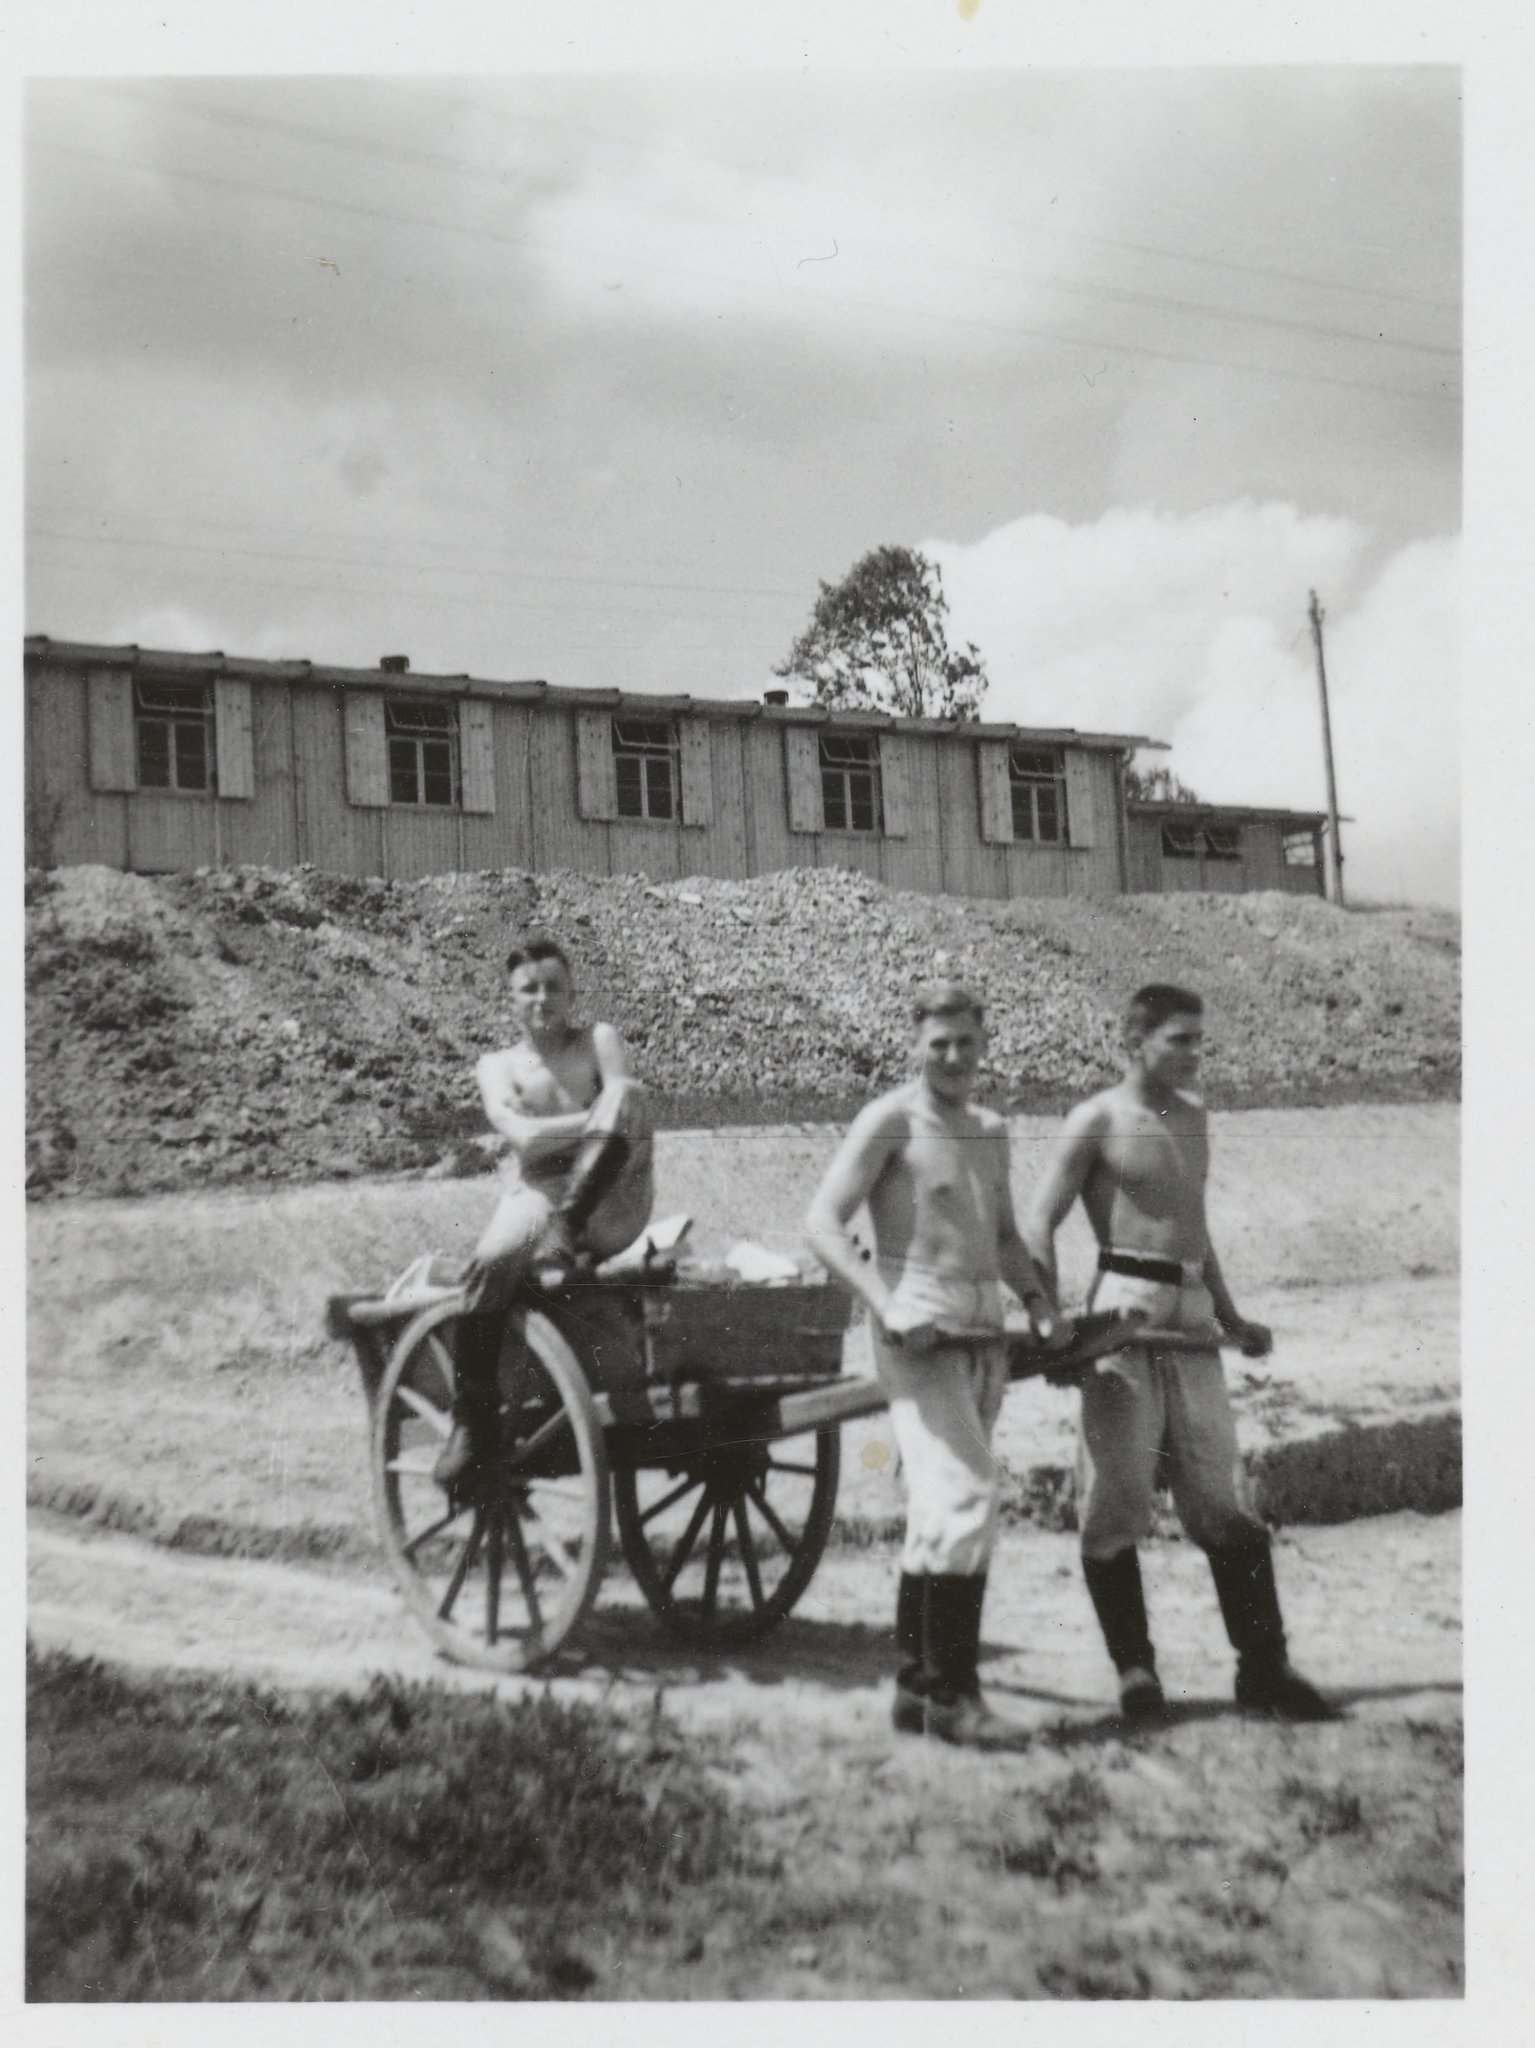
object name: photograph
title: Drie mannen trekken een kar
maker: Anonymous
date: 1940-1945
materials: photographic support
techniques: gelatin silver print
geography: germany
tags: netherlands, germany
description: Drie mannen met bloot bovenlijf trekken een kar. Op de achtergrond een barak. Op achterzijde Duits opschrift. Foto behorend bij album 'Kriegserinnerungen'.